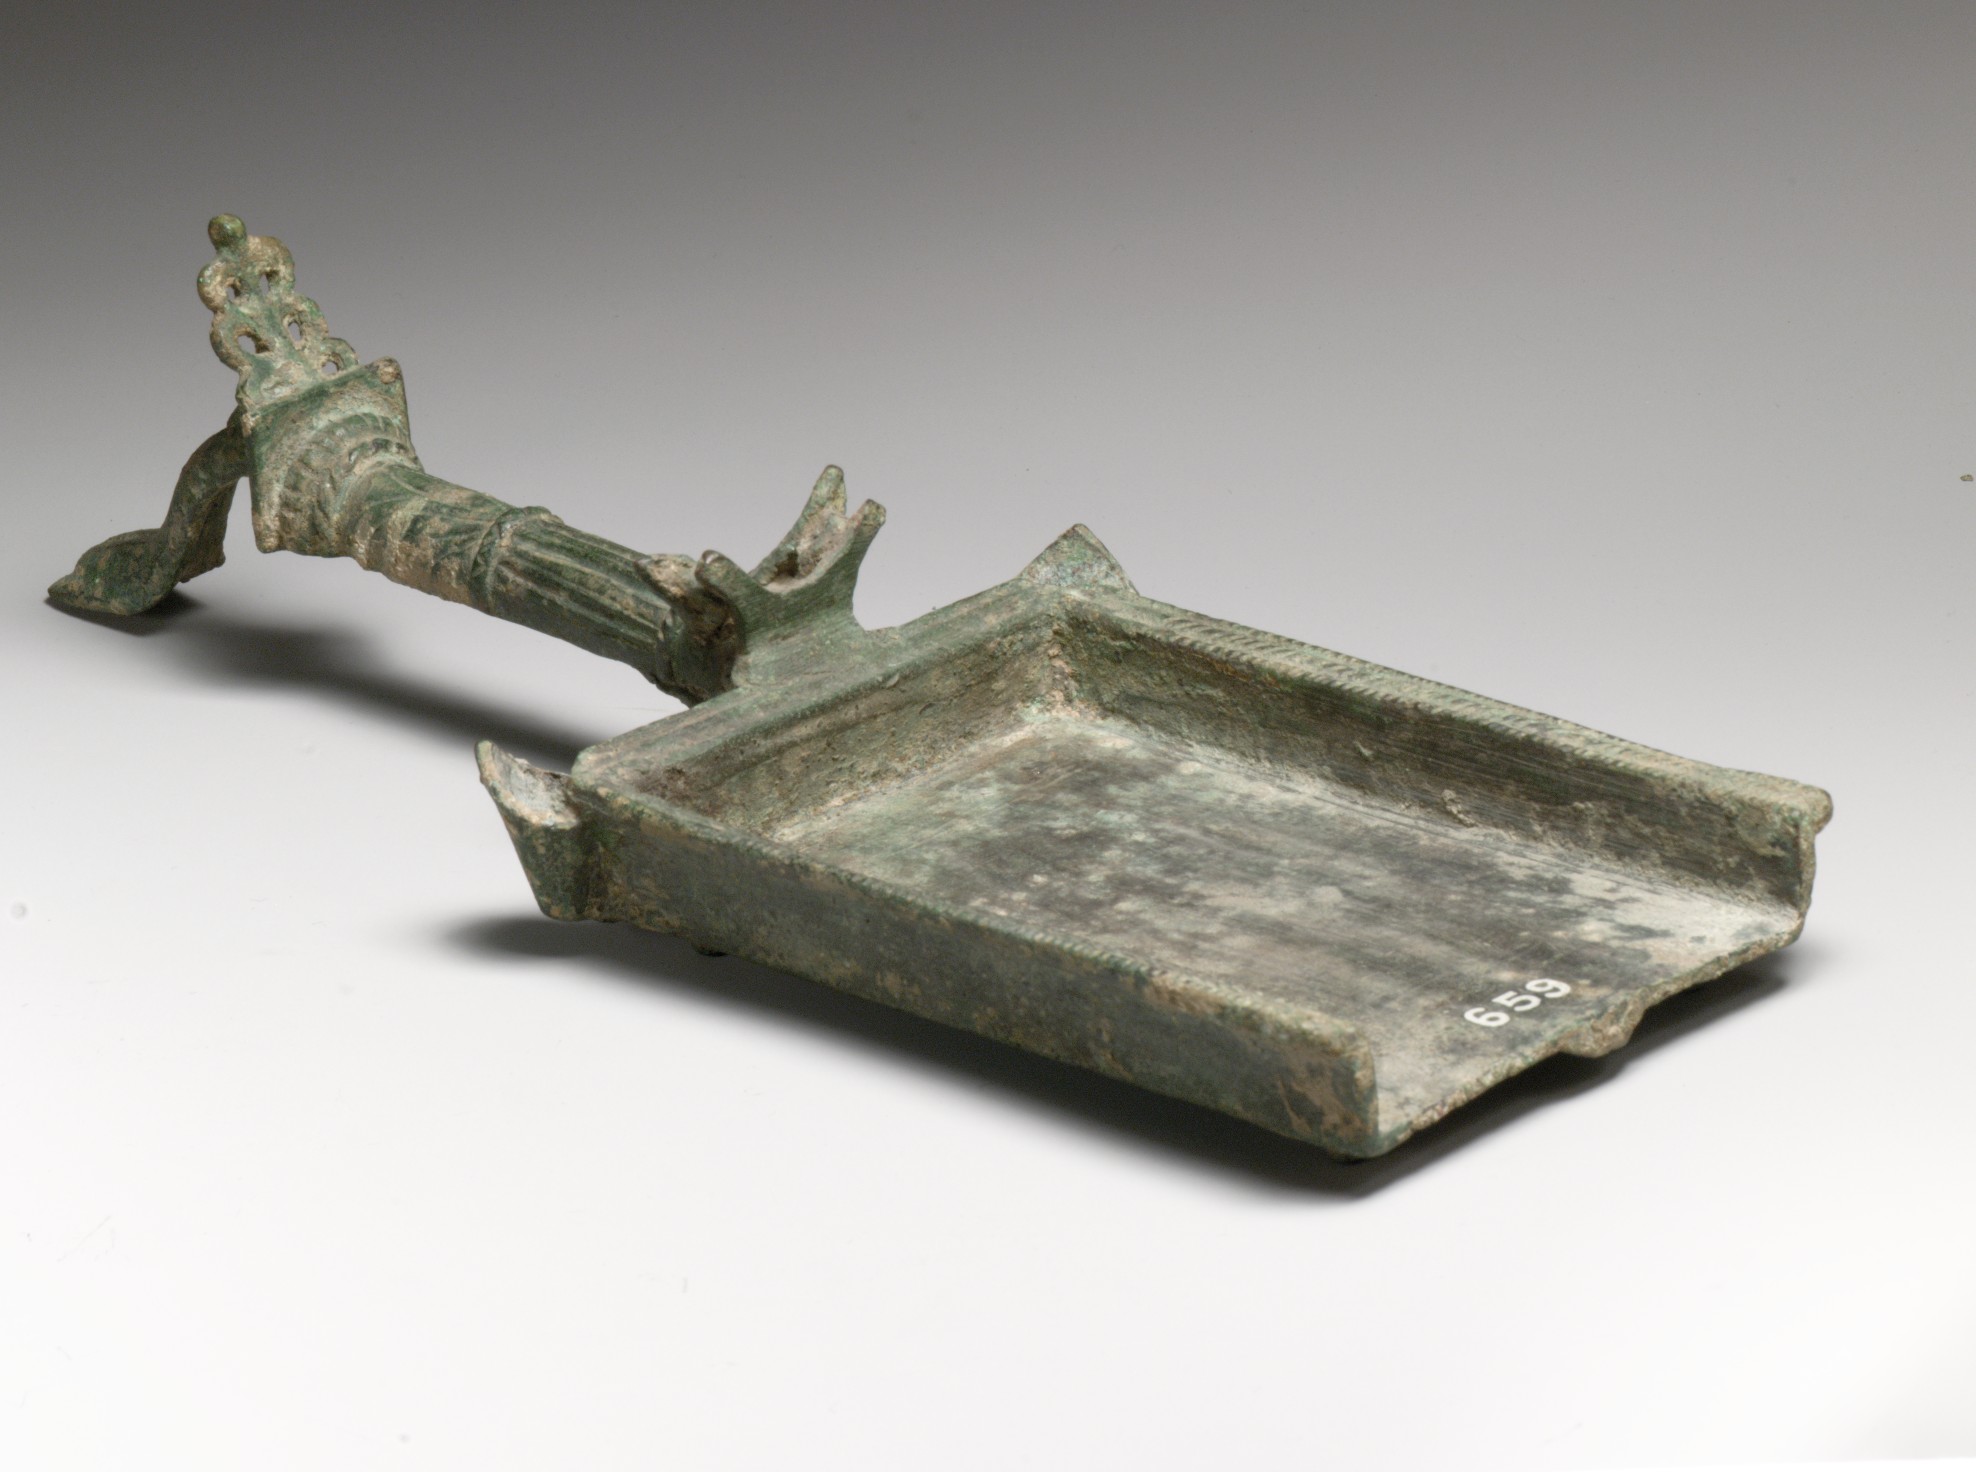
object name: shovel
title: Bronze batillum (incense shovel)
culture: roman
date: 67-133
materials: bronze